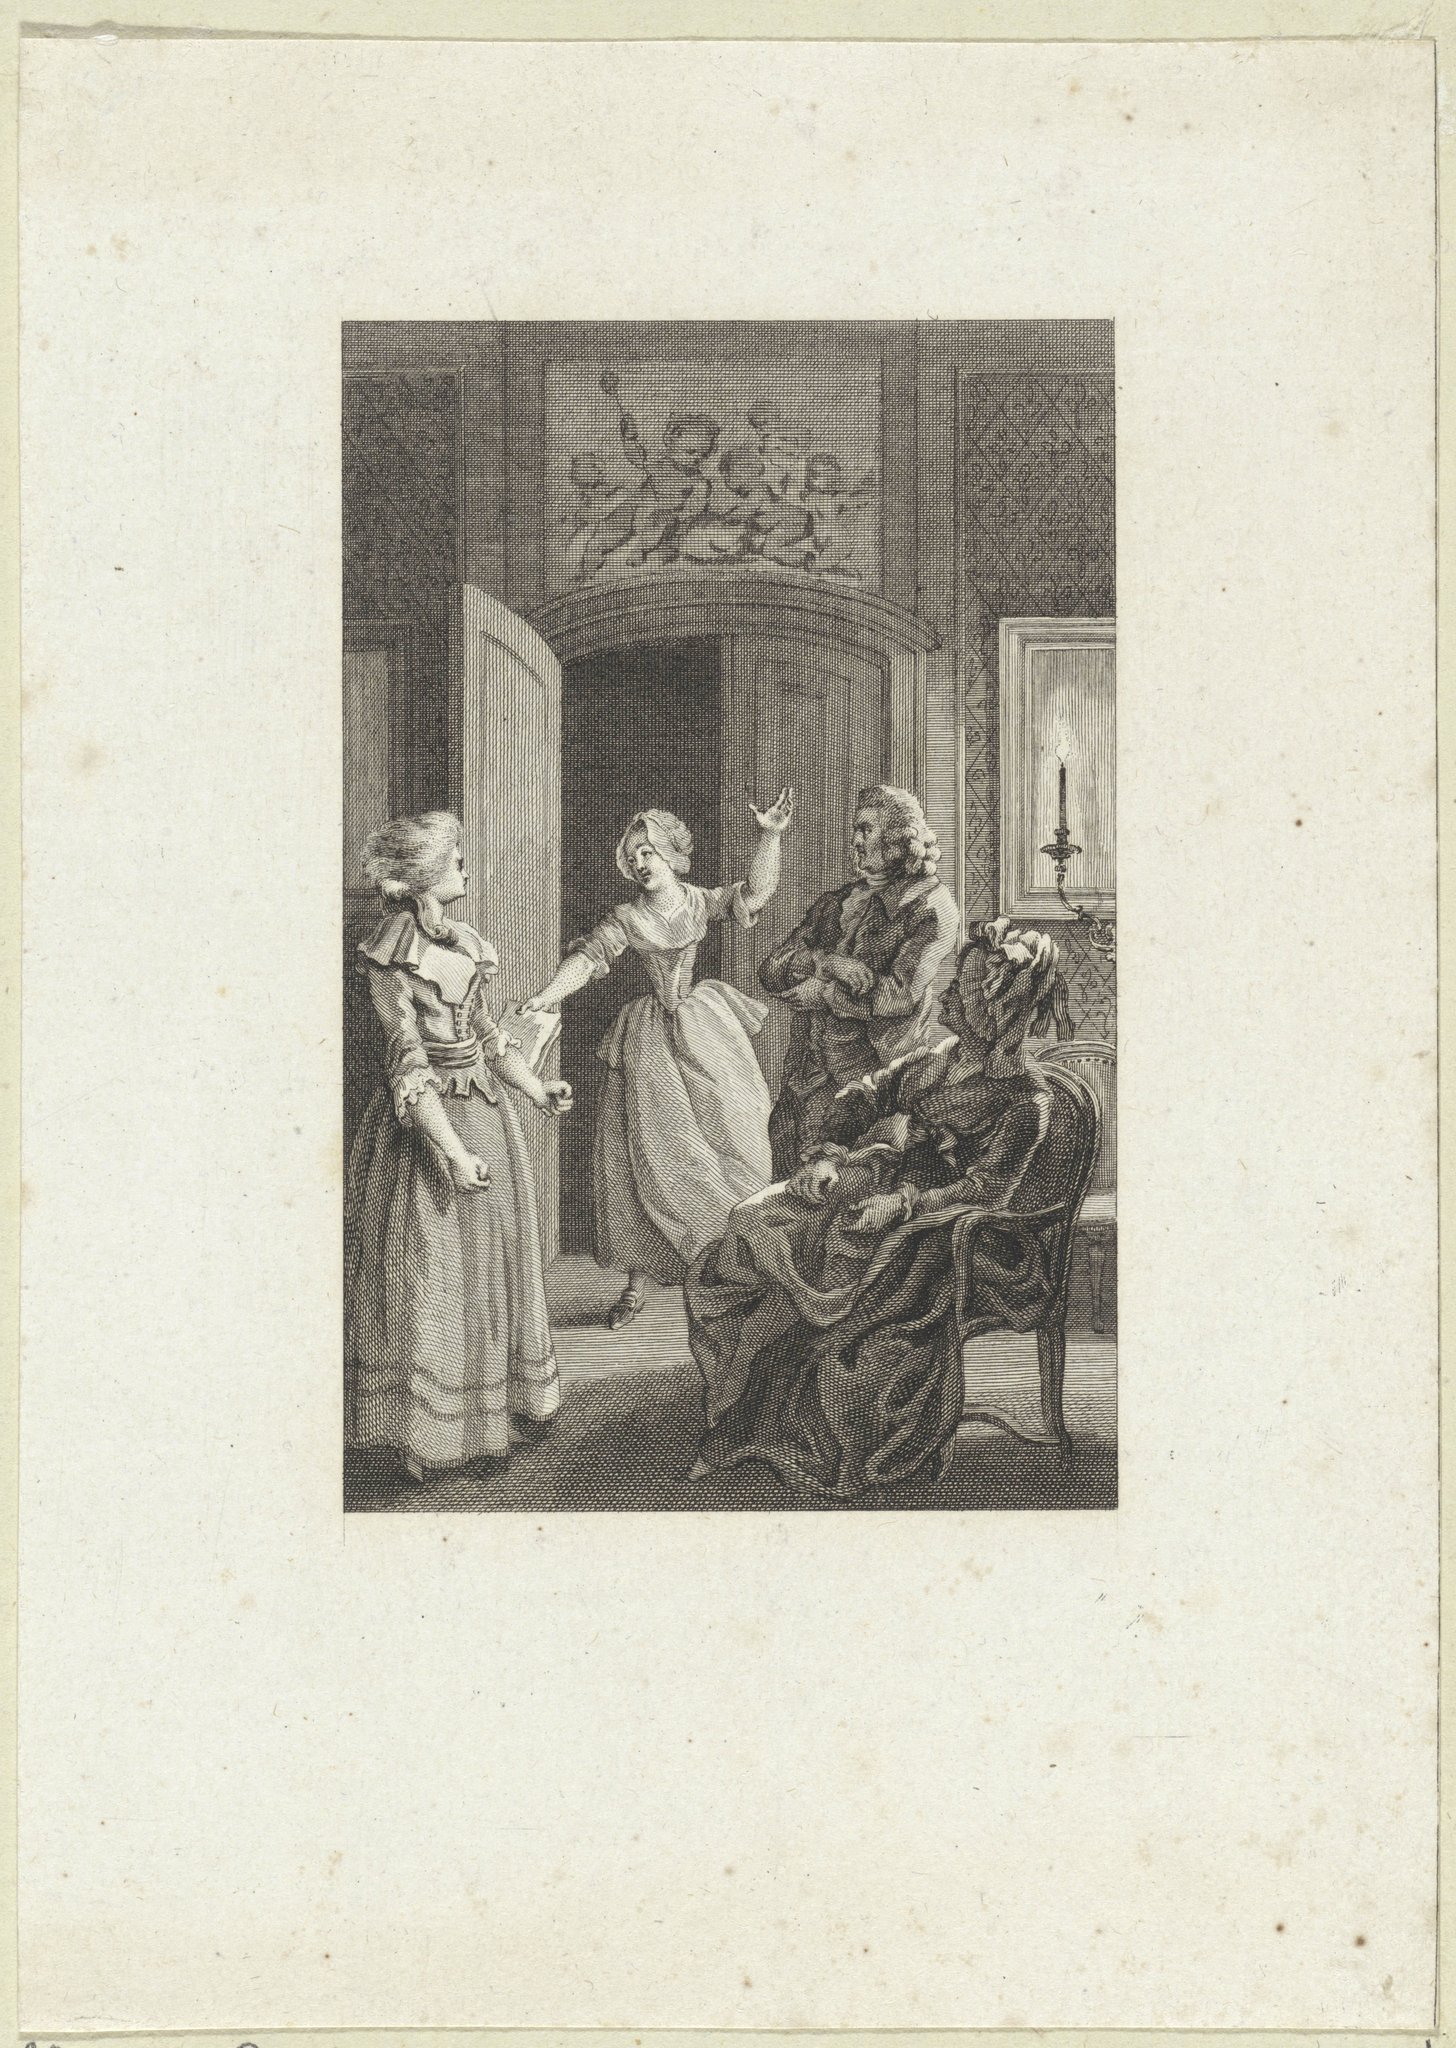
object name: print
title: Jonge vrouw komt met een beschreven papier een vertrek binnen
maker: reinier vinkeles (i)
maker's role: draughtsman, print maker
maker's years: 1741-1816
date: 1788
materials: paper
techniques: engraving, etching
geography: amsterdam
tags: interruption, questions (~ meeting), handwriting, written text, candle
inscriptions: collector's mark: Lugt 240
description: Een jonge vrouw komt een vertrek binnen met een stapel beschreven papier in de hand. De drie figuren in het vertrek kijken naar haar, een dame heeft haar vuisten gebald.